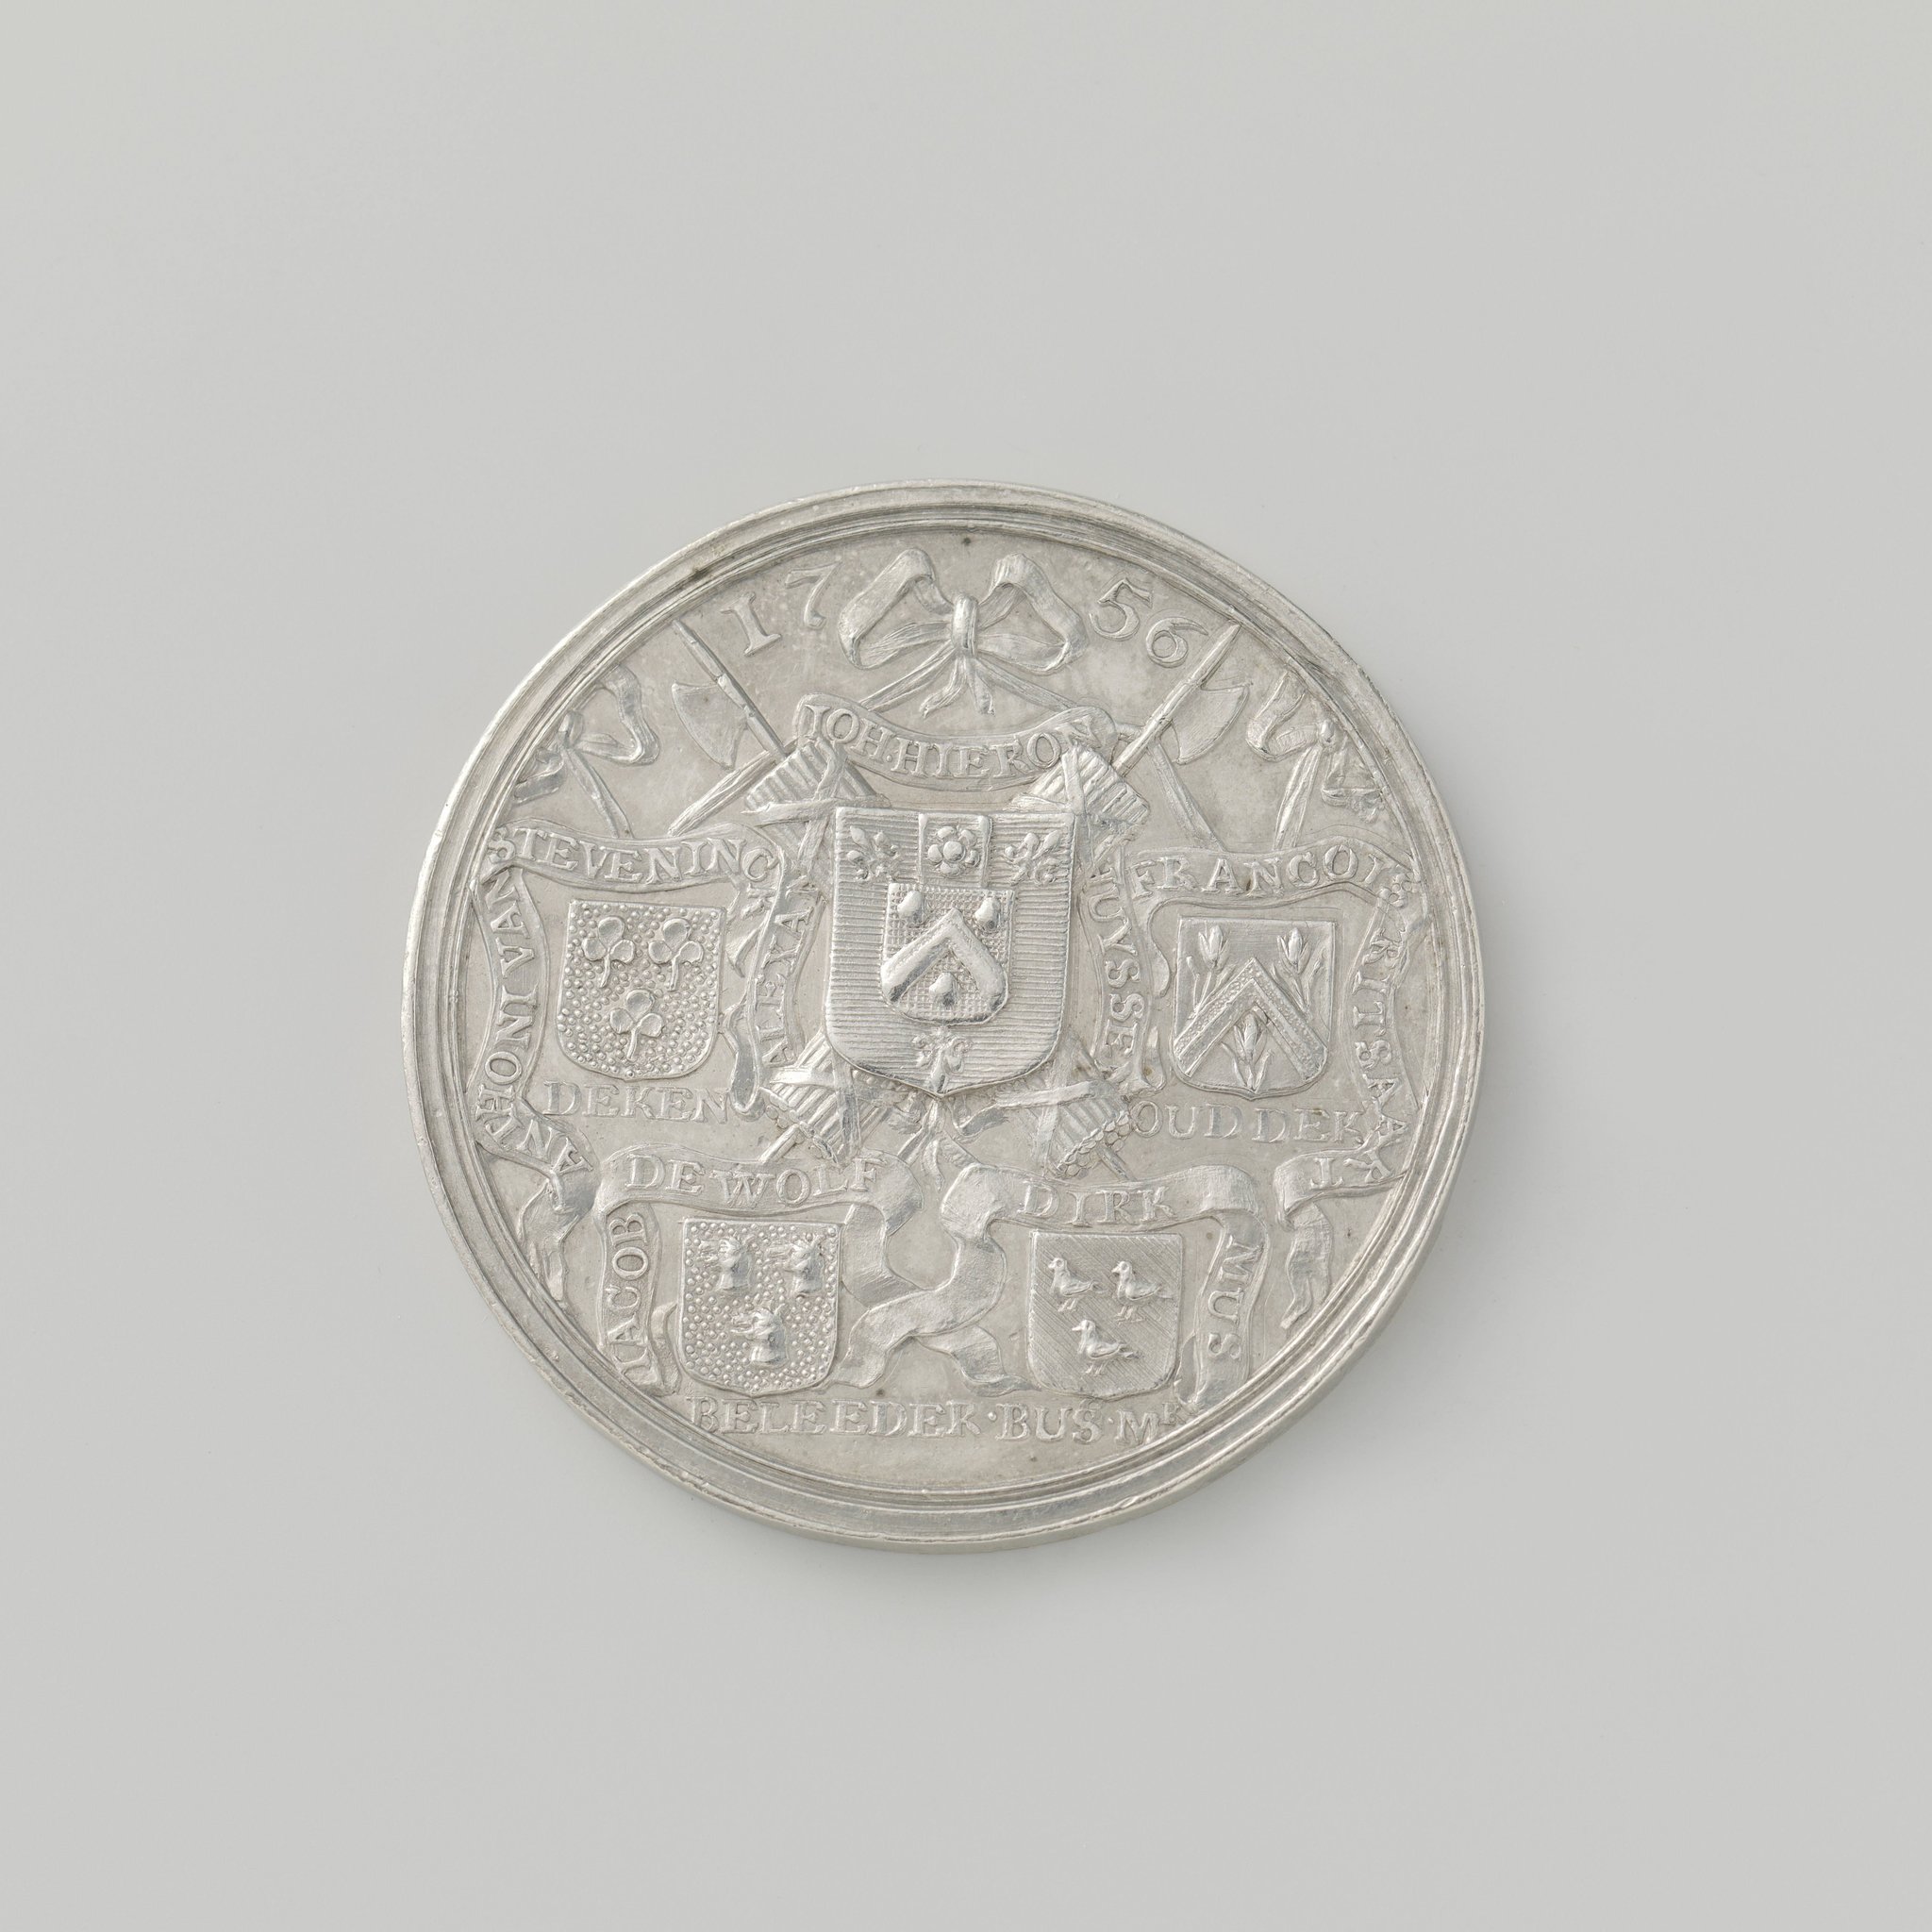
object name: medal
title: Surgeons’ Guild, with Number 22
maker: Anonymous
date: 1756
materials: silver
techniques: casting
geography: middelburg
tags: middelburg